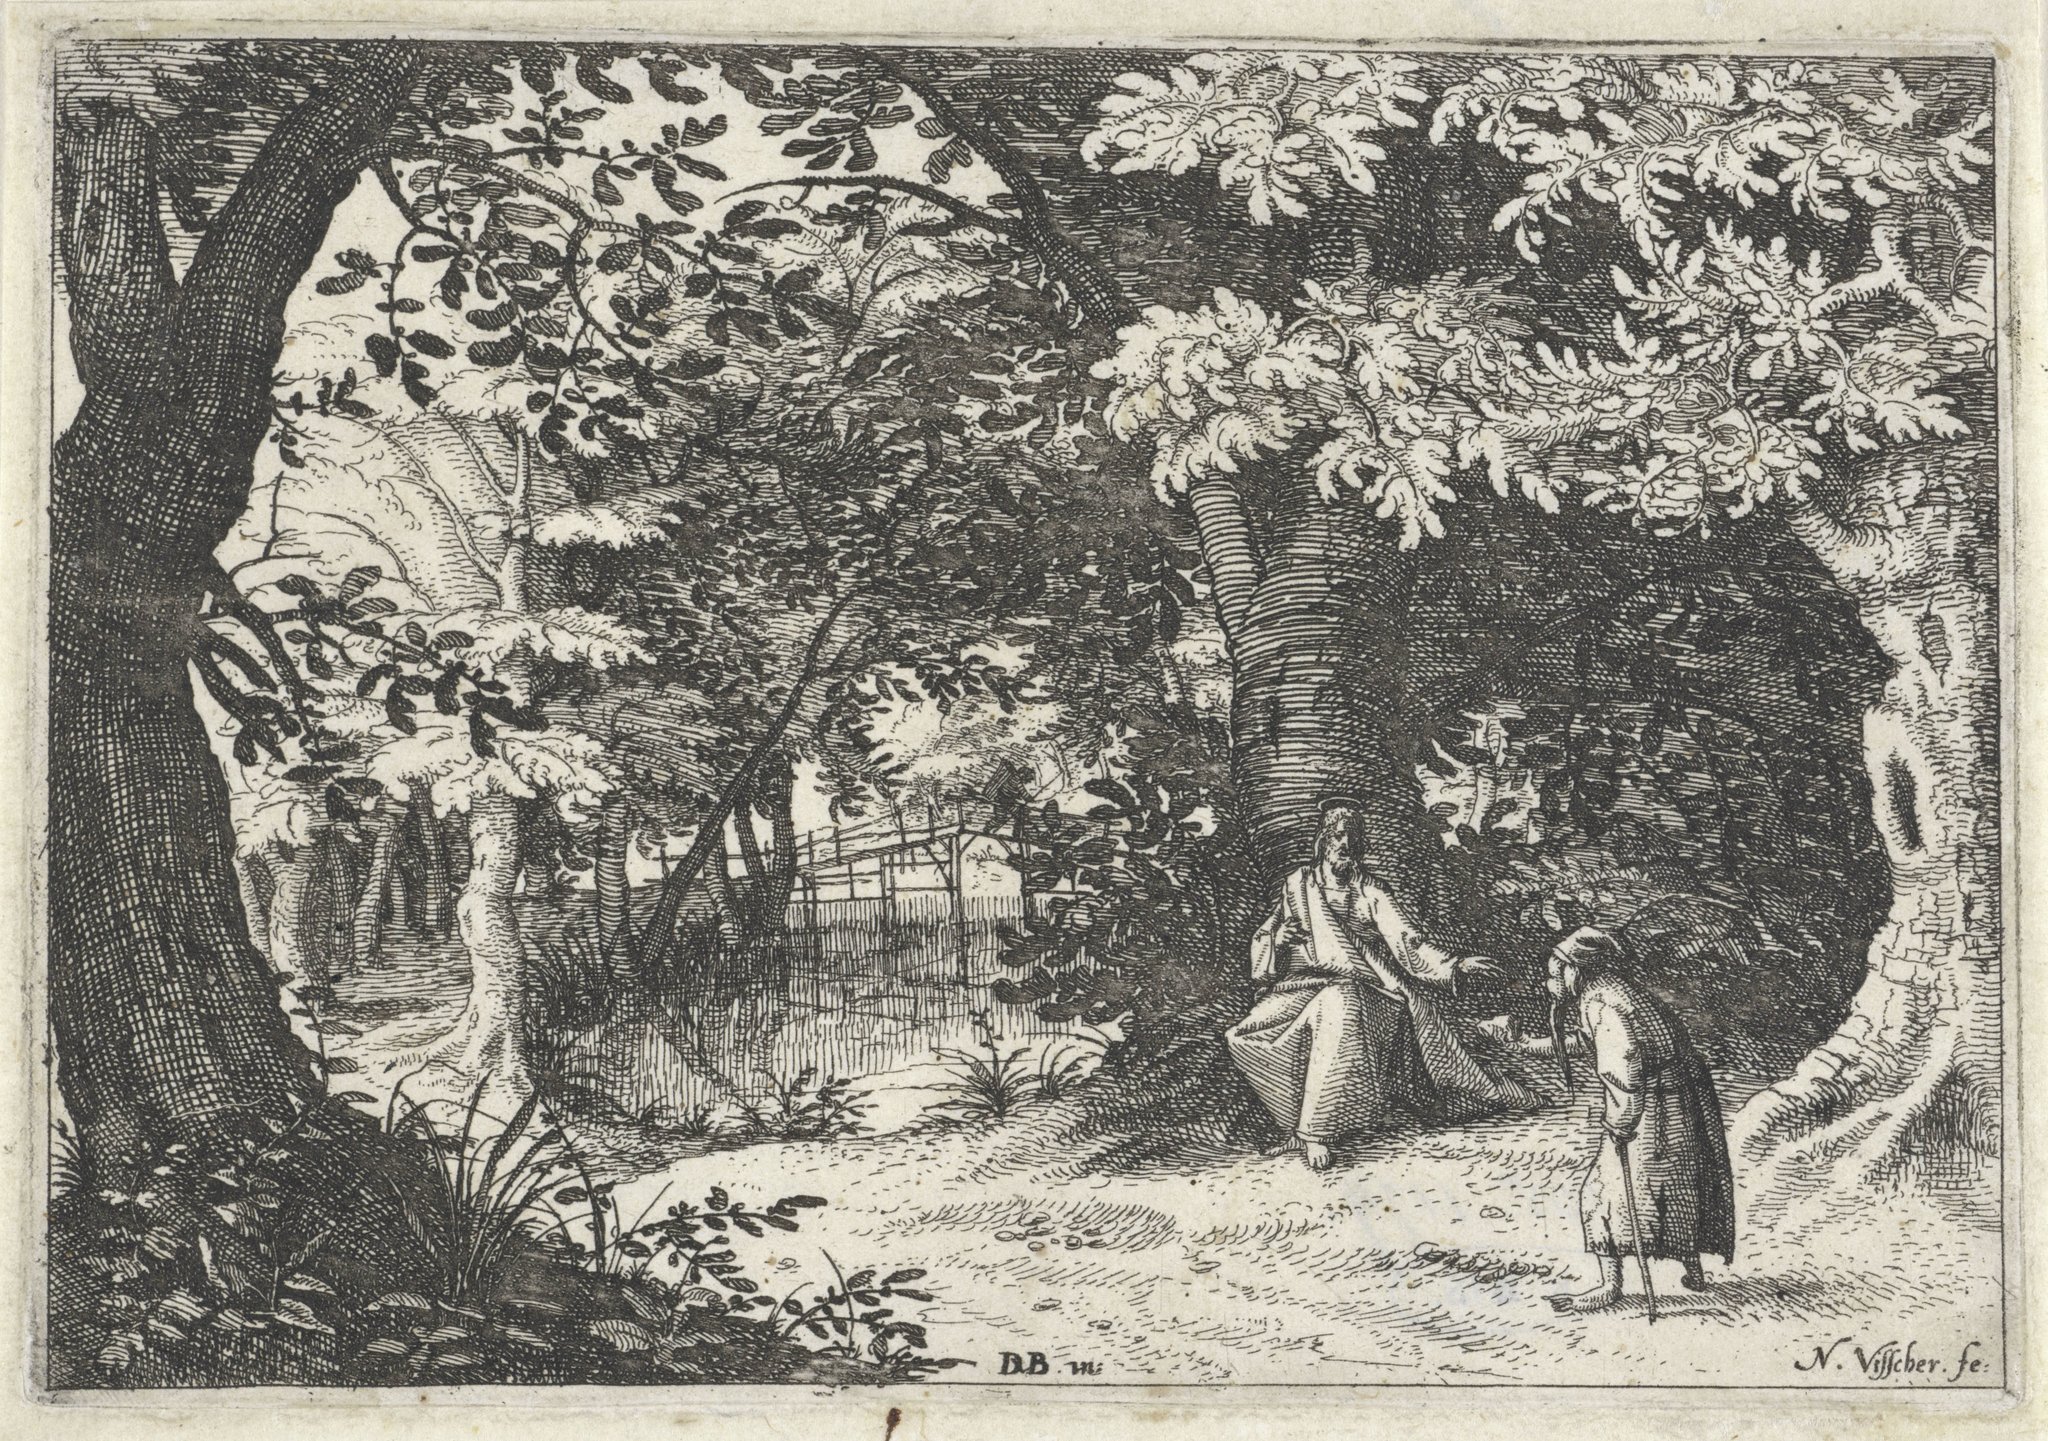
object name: print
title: Verzoeking van Christus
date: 1596-1630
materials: paper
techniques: etching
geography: amsterdam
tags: christ, sometimes accompanied by guardian angel(s), tempted by satan, who usually appears in human form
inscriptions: collector's mark: 2228, monogram: ‘DvB in:’, signature: ‘N. Visscher fe.’ Lugt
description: Christus zit in een boslandschap, onder een dikke boom. Voor hem de duivel in de gedaante van een oude man, leunend op een stok. Linksachter een houten bruggetje.